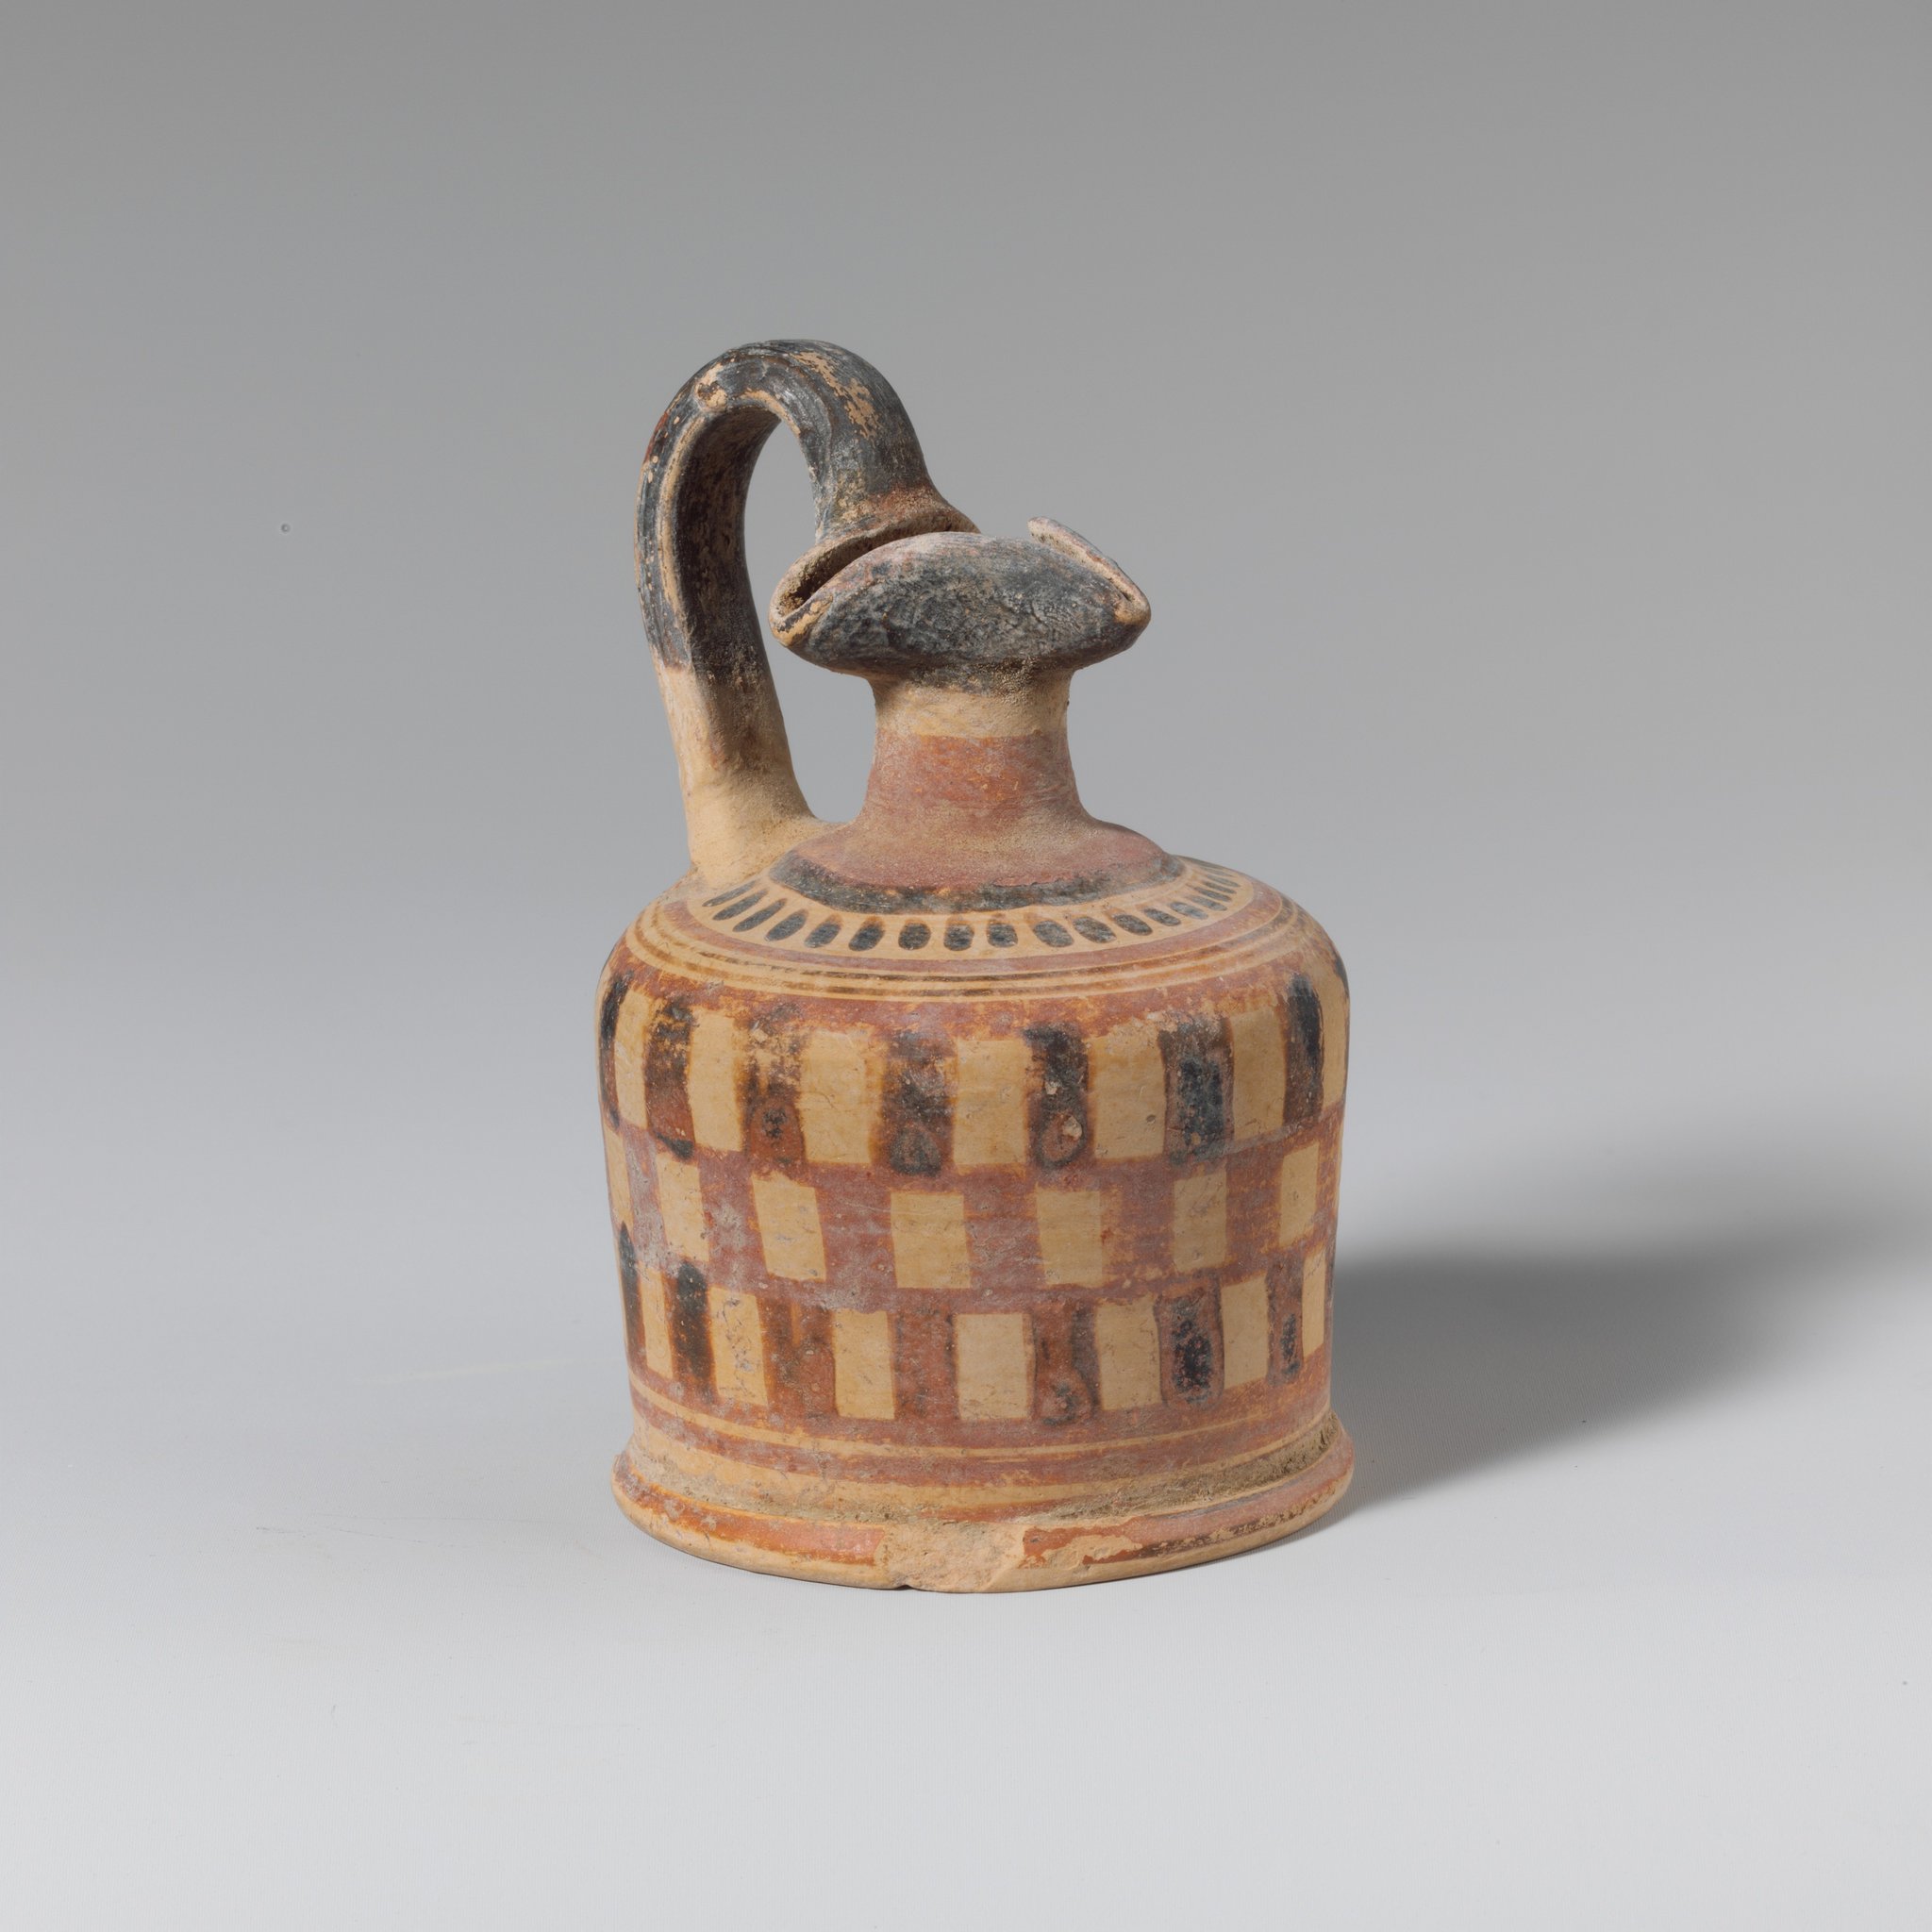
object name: oinochoe, trefoil squat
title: Terracotta oinochoe (jug)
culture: greek, corinthian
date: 534-501 BCE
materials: terracotta